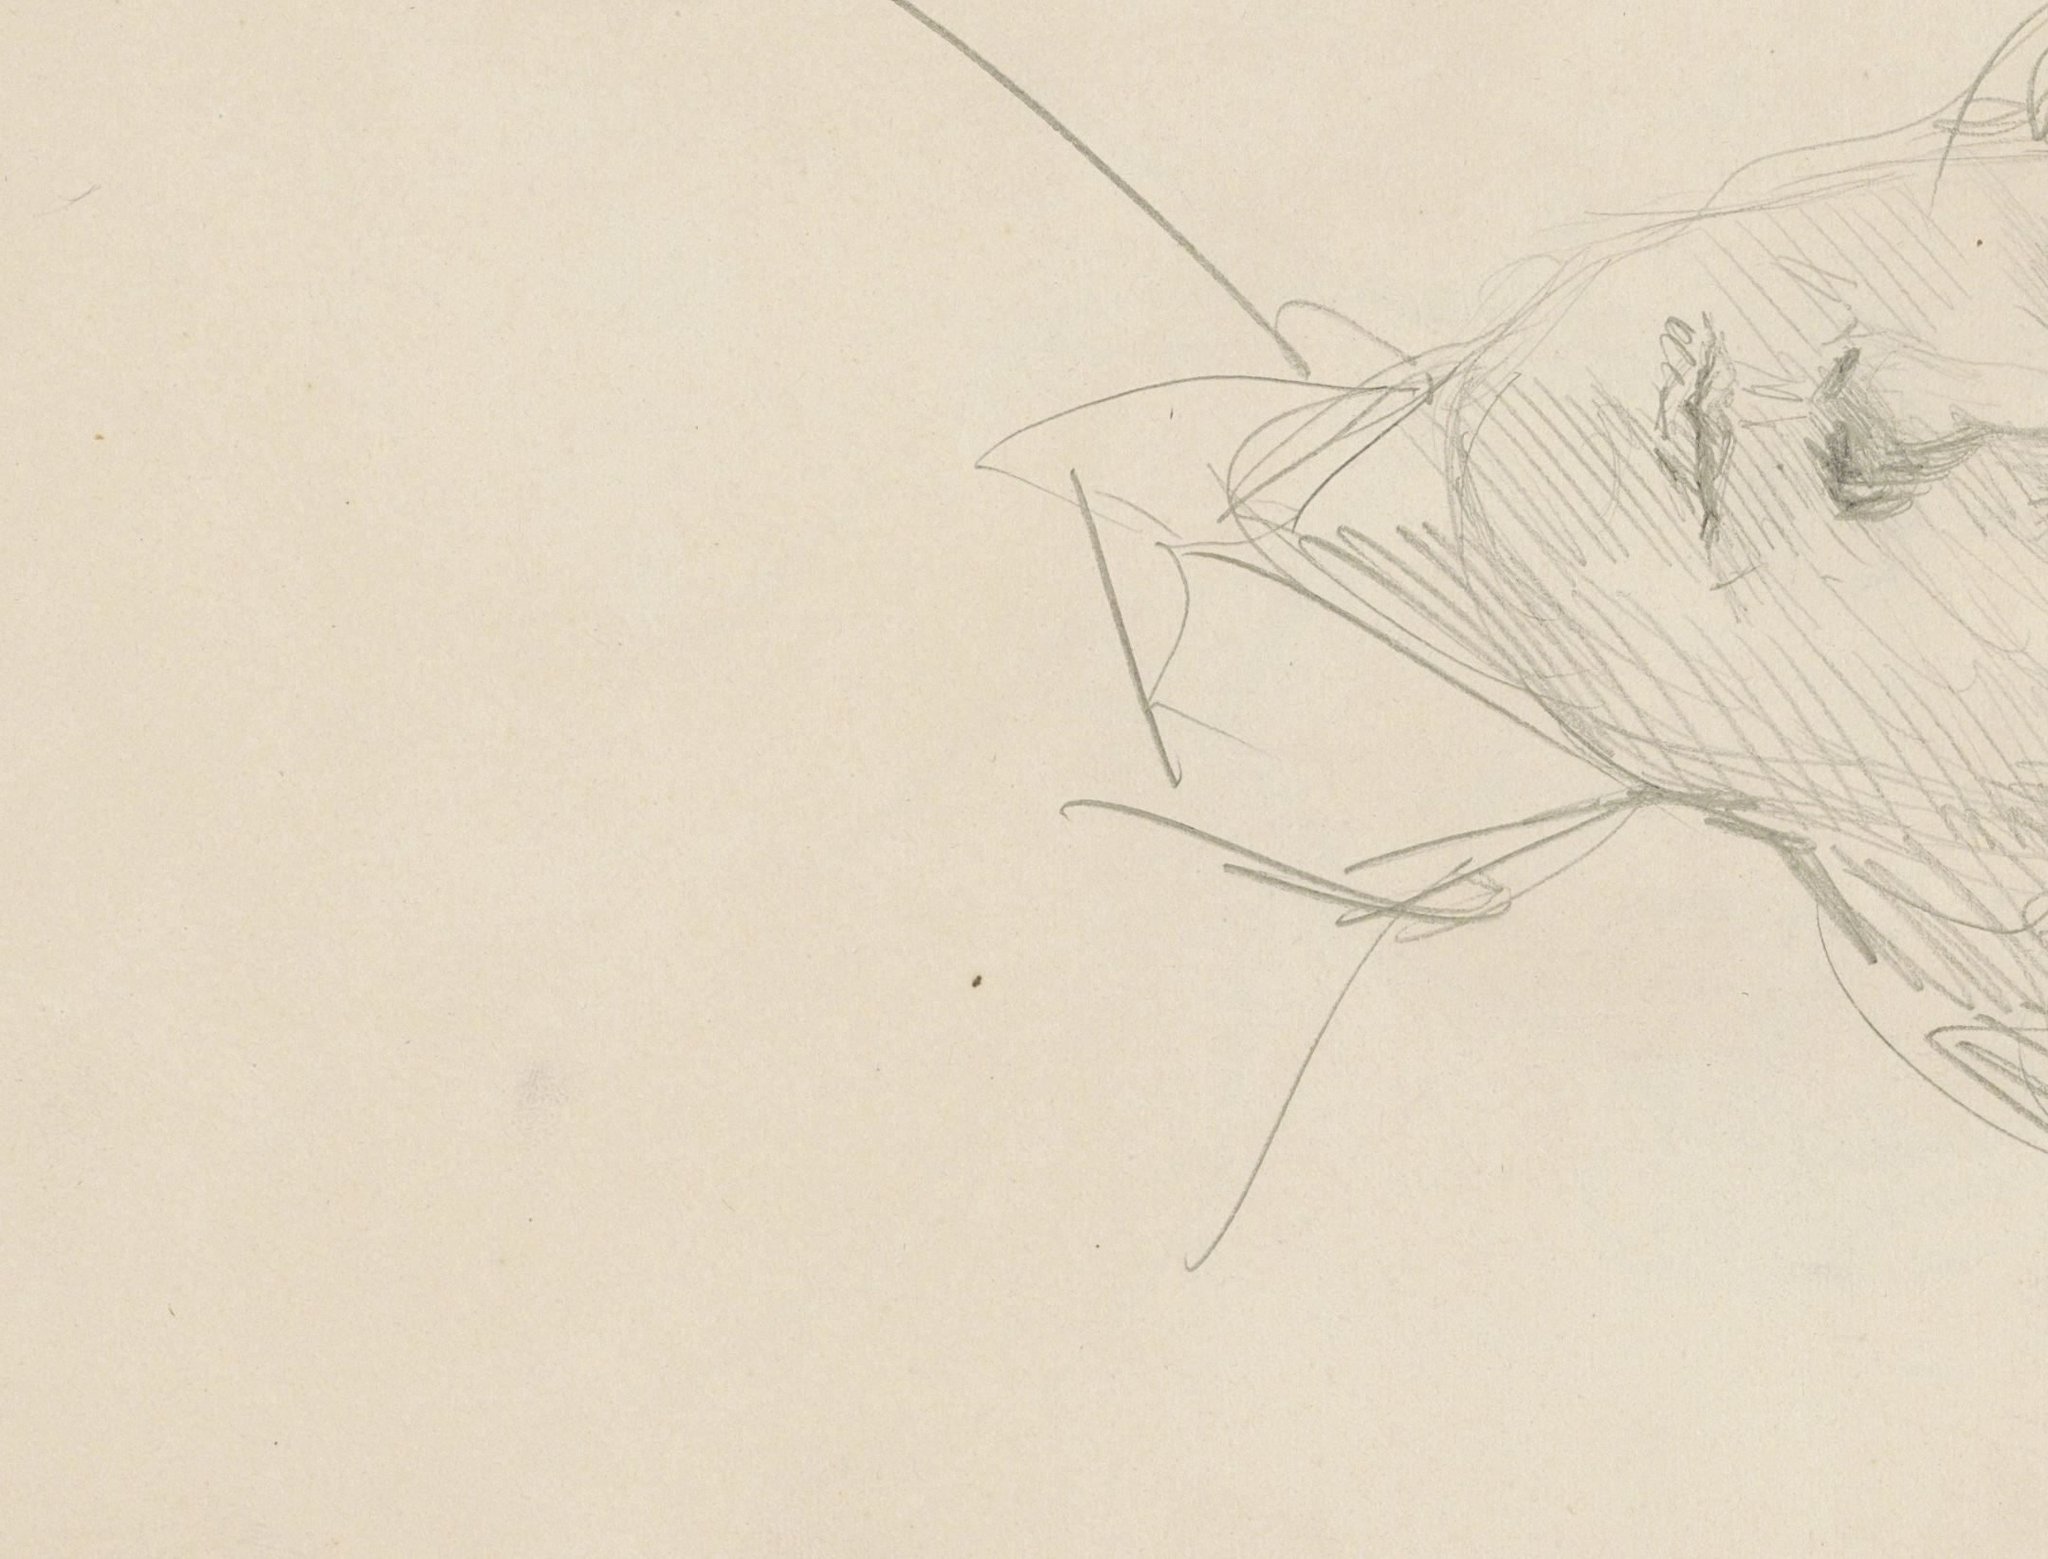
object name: sketchbook leaf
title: Vrouwenhoofd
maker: isaac israels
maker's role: draughtsman, painter, print maker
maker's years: 1865-1934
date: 1875-1934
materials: paper, pencil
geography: the hague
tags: head (human) - aa - female human figure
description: Blad 4 recto uit schetsboek XXIII met 20 bladen.